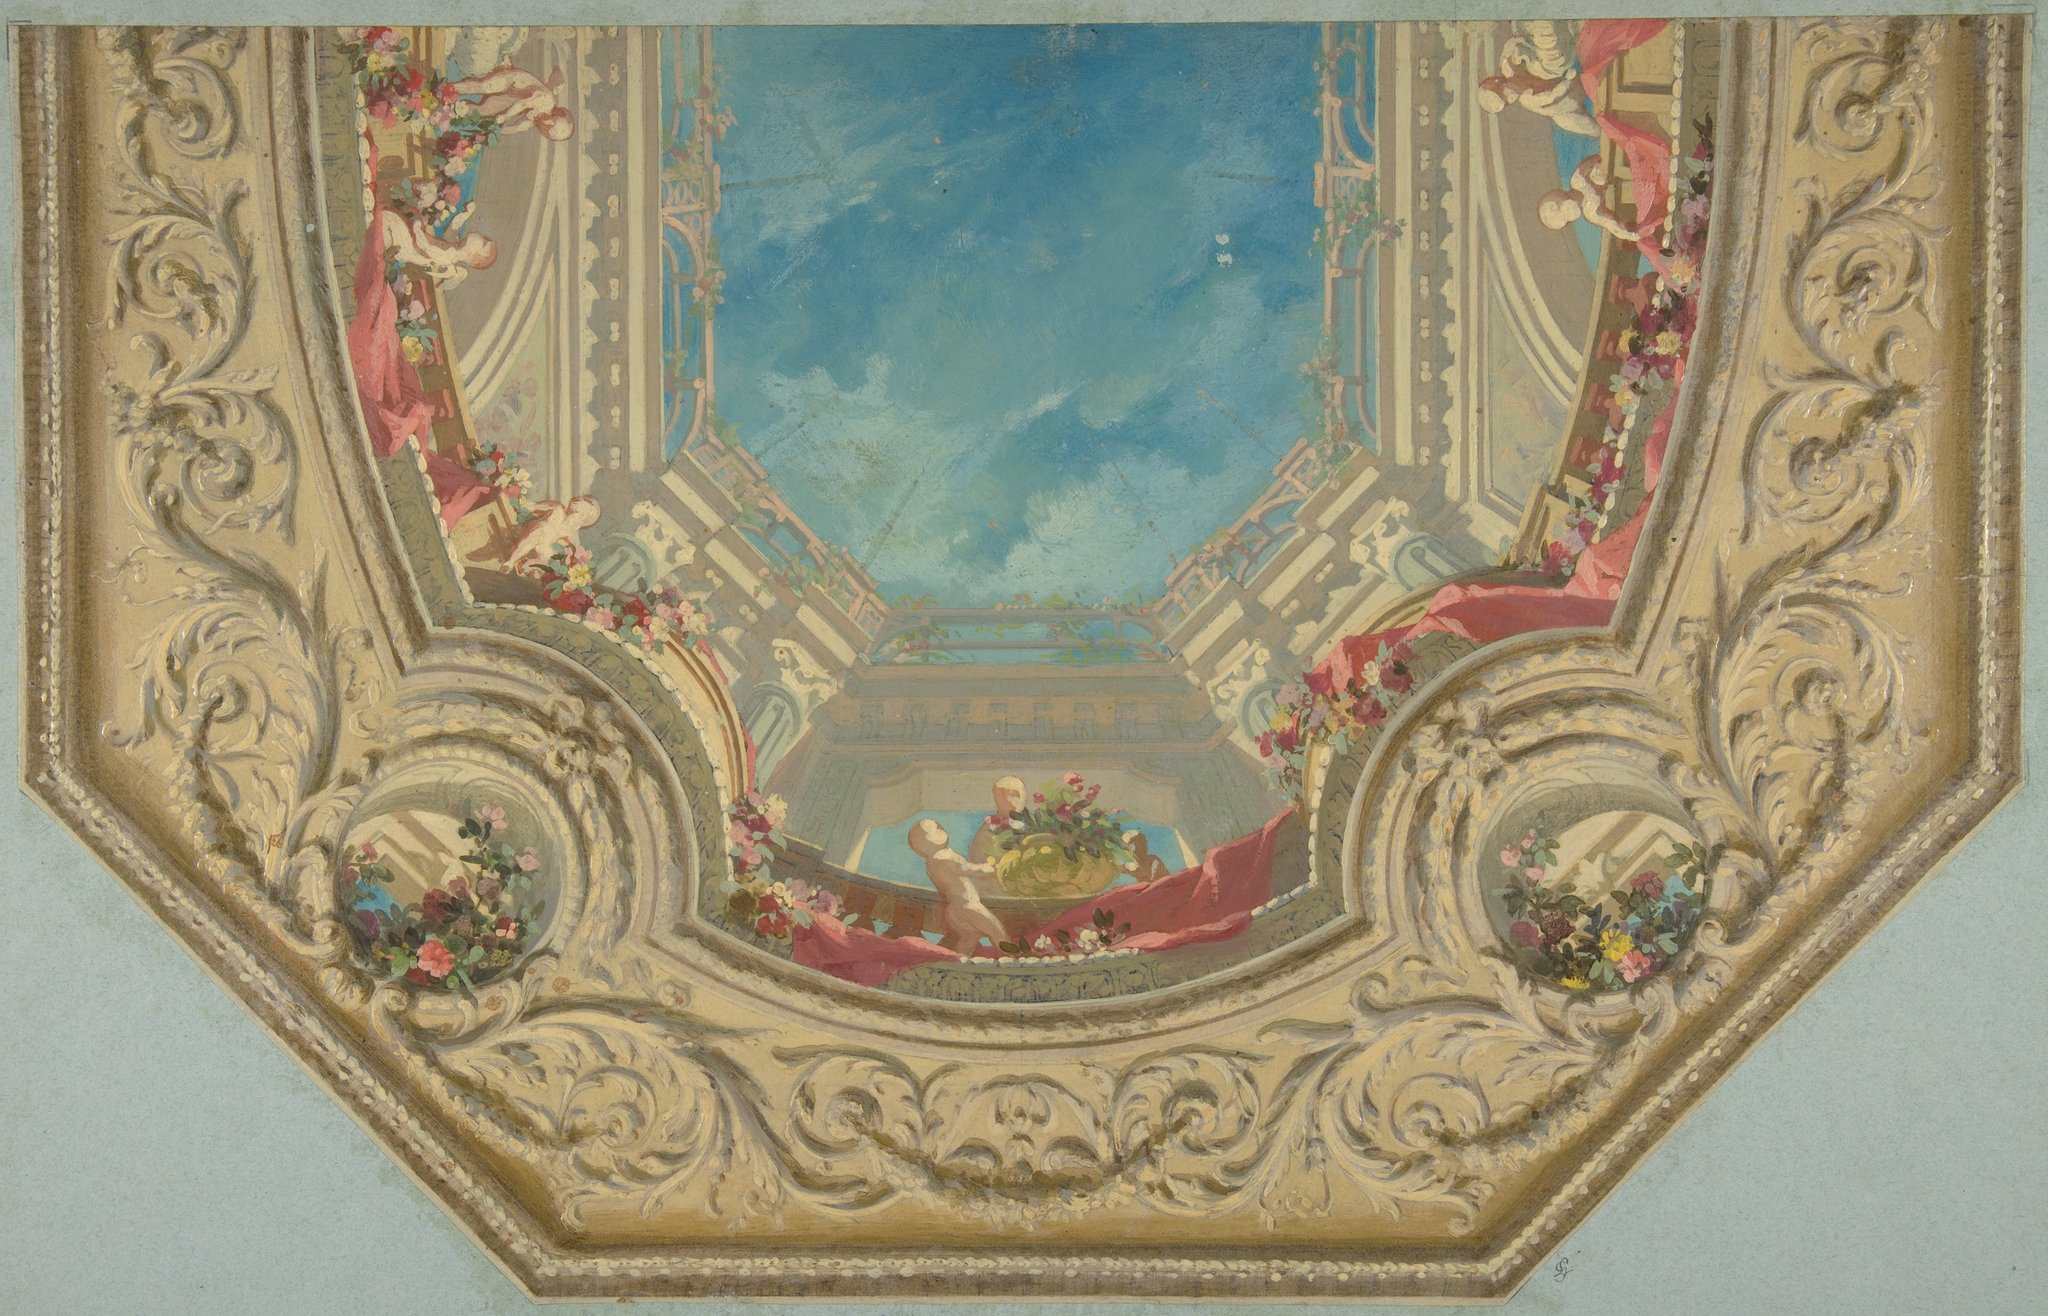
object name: drawing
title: Design for Octagonal Ceiling in the Pless House, Berlin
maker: jules-edmond-charles lachaise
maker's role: artist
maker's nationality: french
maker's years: 1897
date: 1851-1900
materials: gouache, paper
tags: human figures,architecture